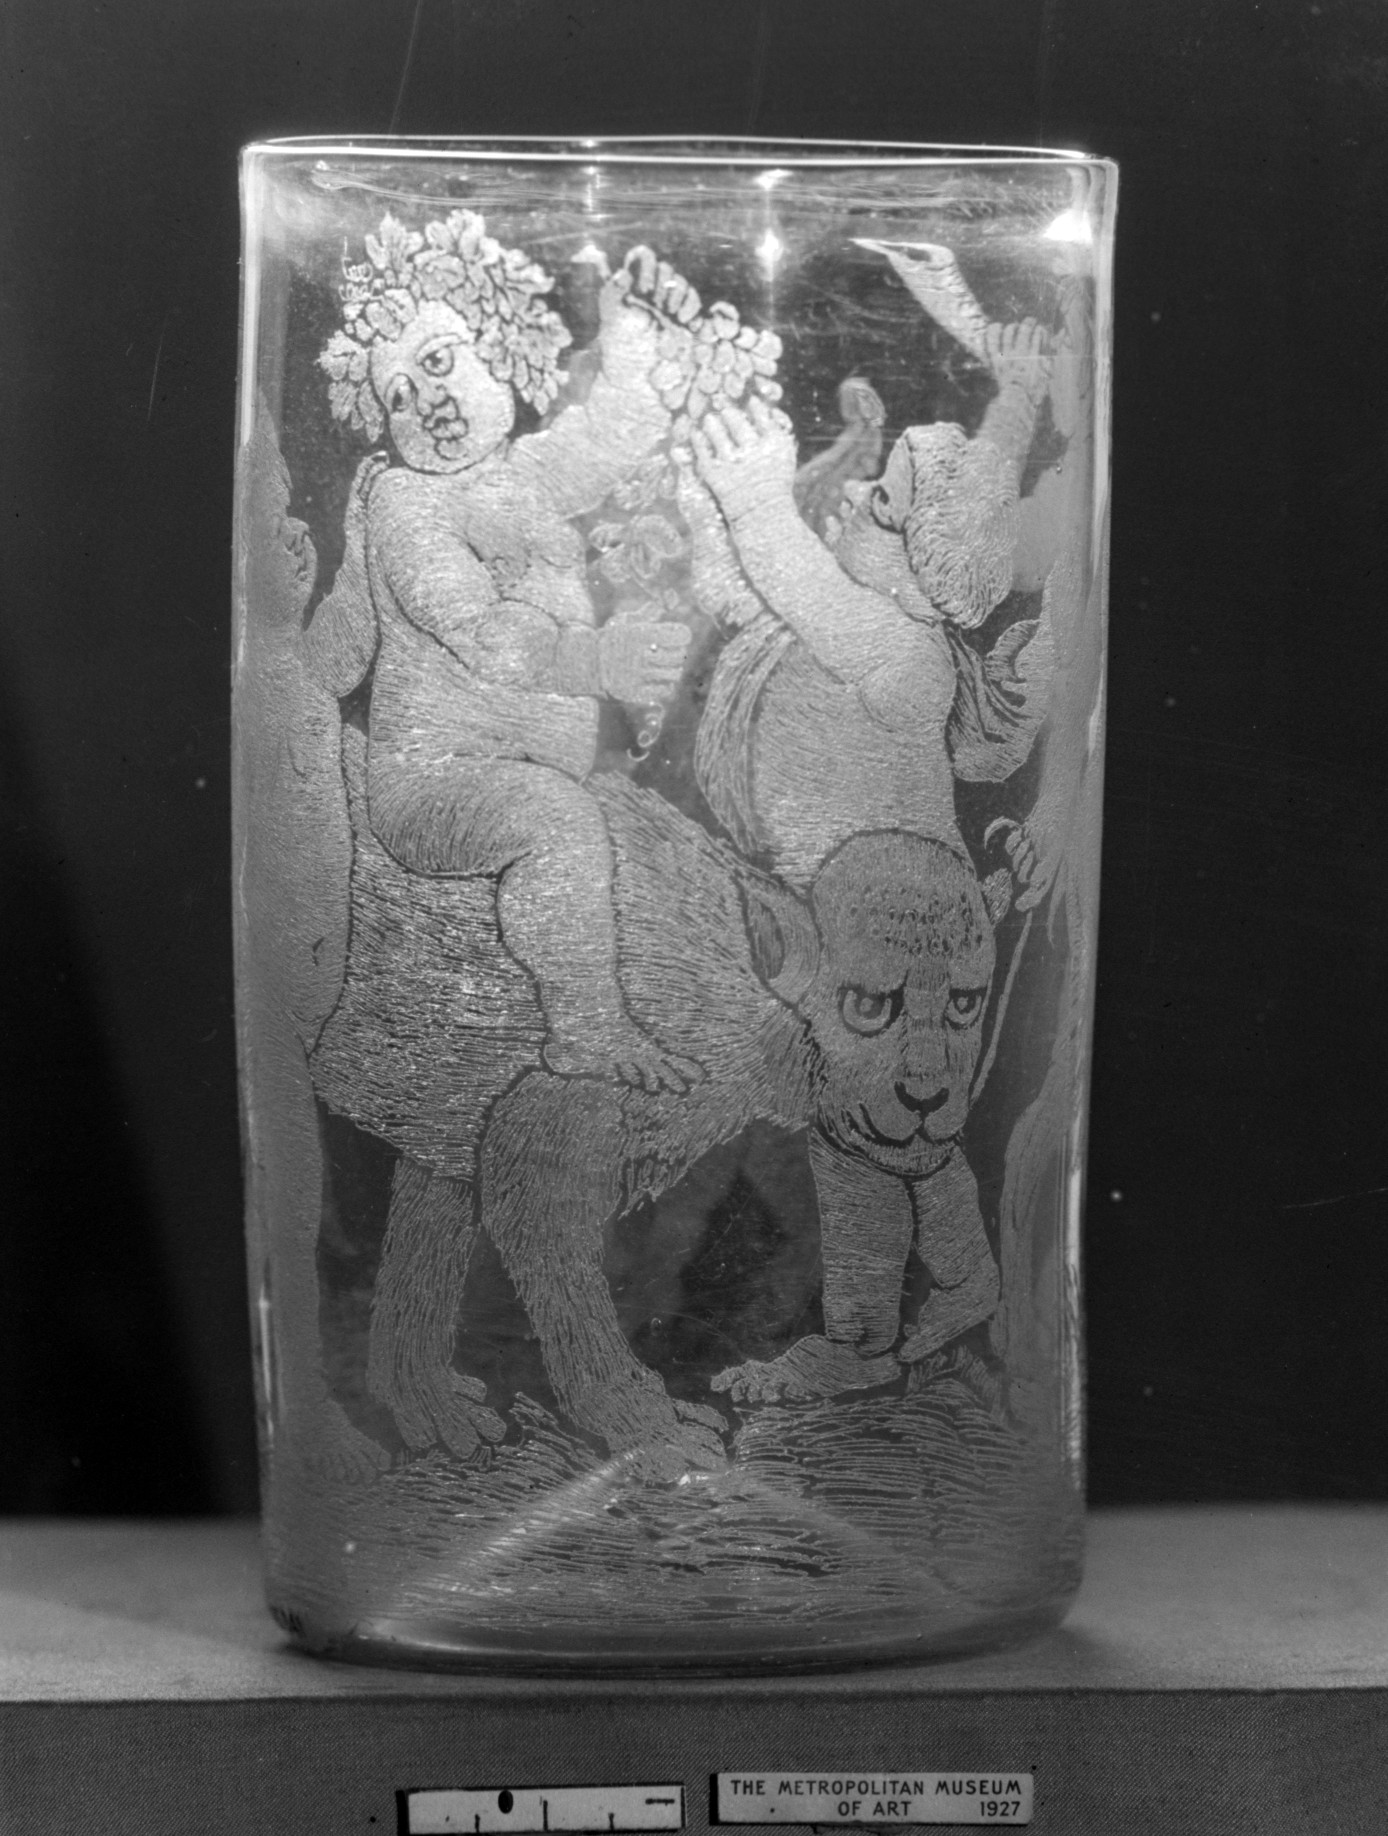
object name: beaker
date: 1651-1700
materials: glass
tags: animals,grapes,putti,tigers